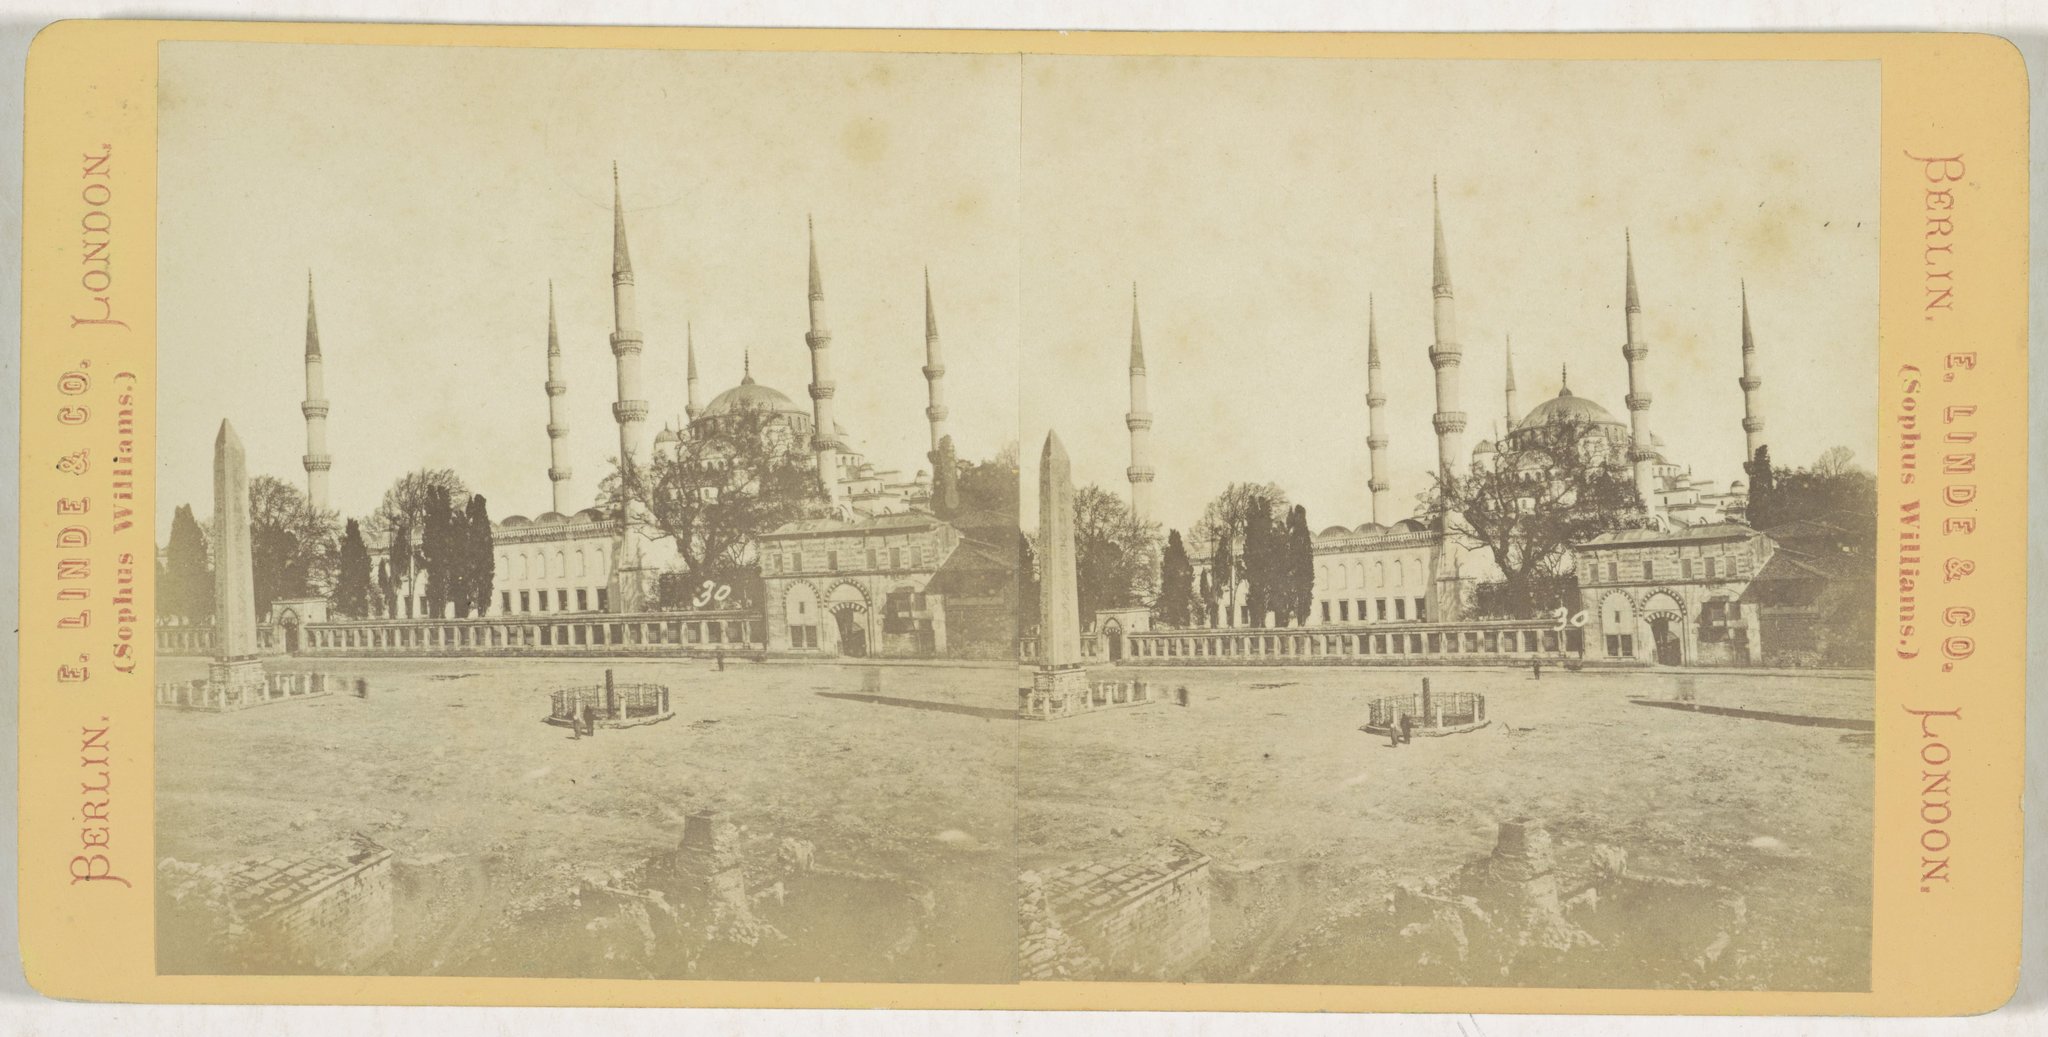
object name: stereograph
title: Moschee des Sultans Hamet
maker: Anonymous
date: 1873-1890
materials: cardboard, paper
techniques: albumen print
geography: sultan ahmetmoskee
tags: temple, shrine ~ islam, mohammedanism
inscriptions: number: ‘30’